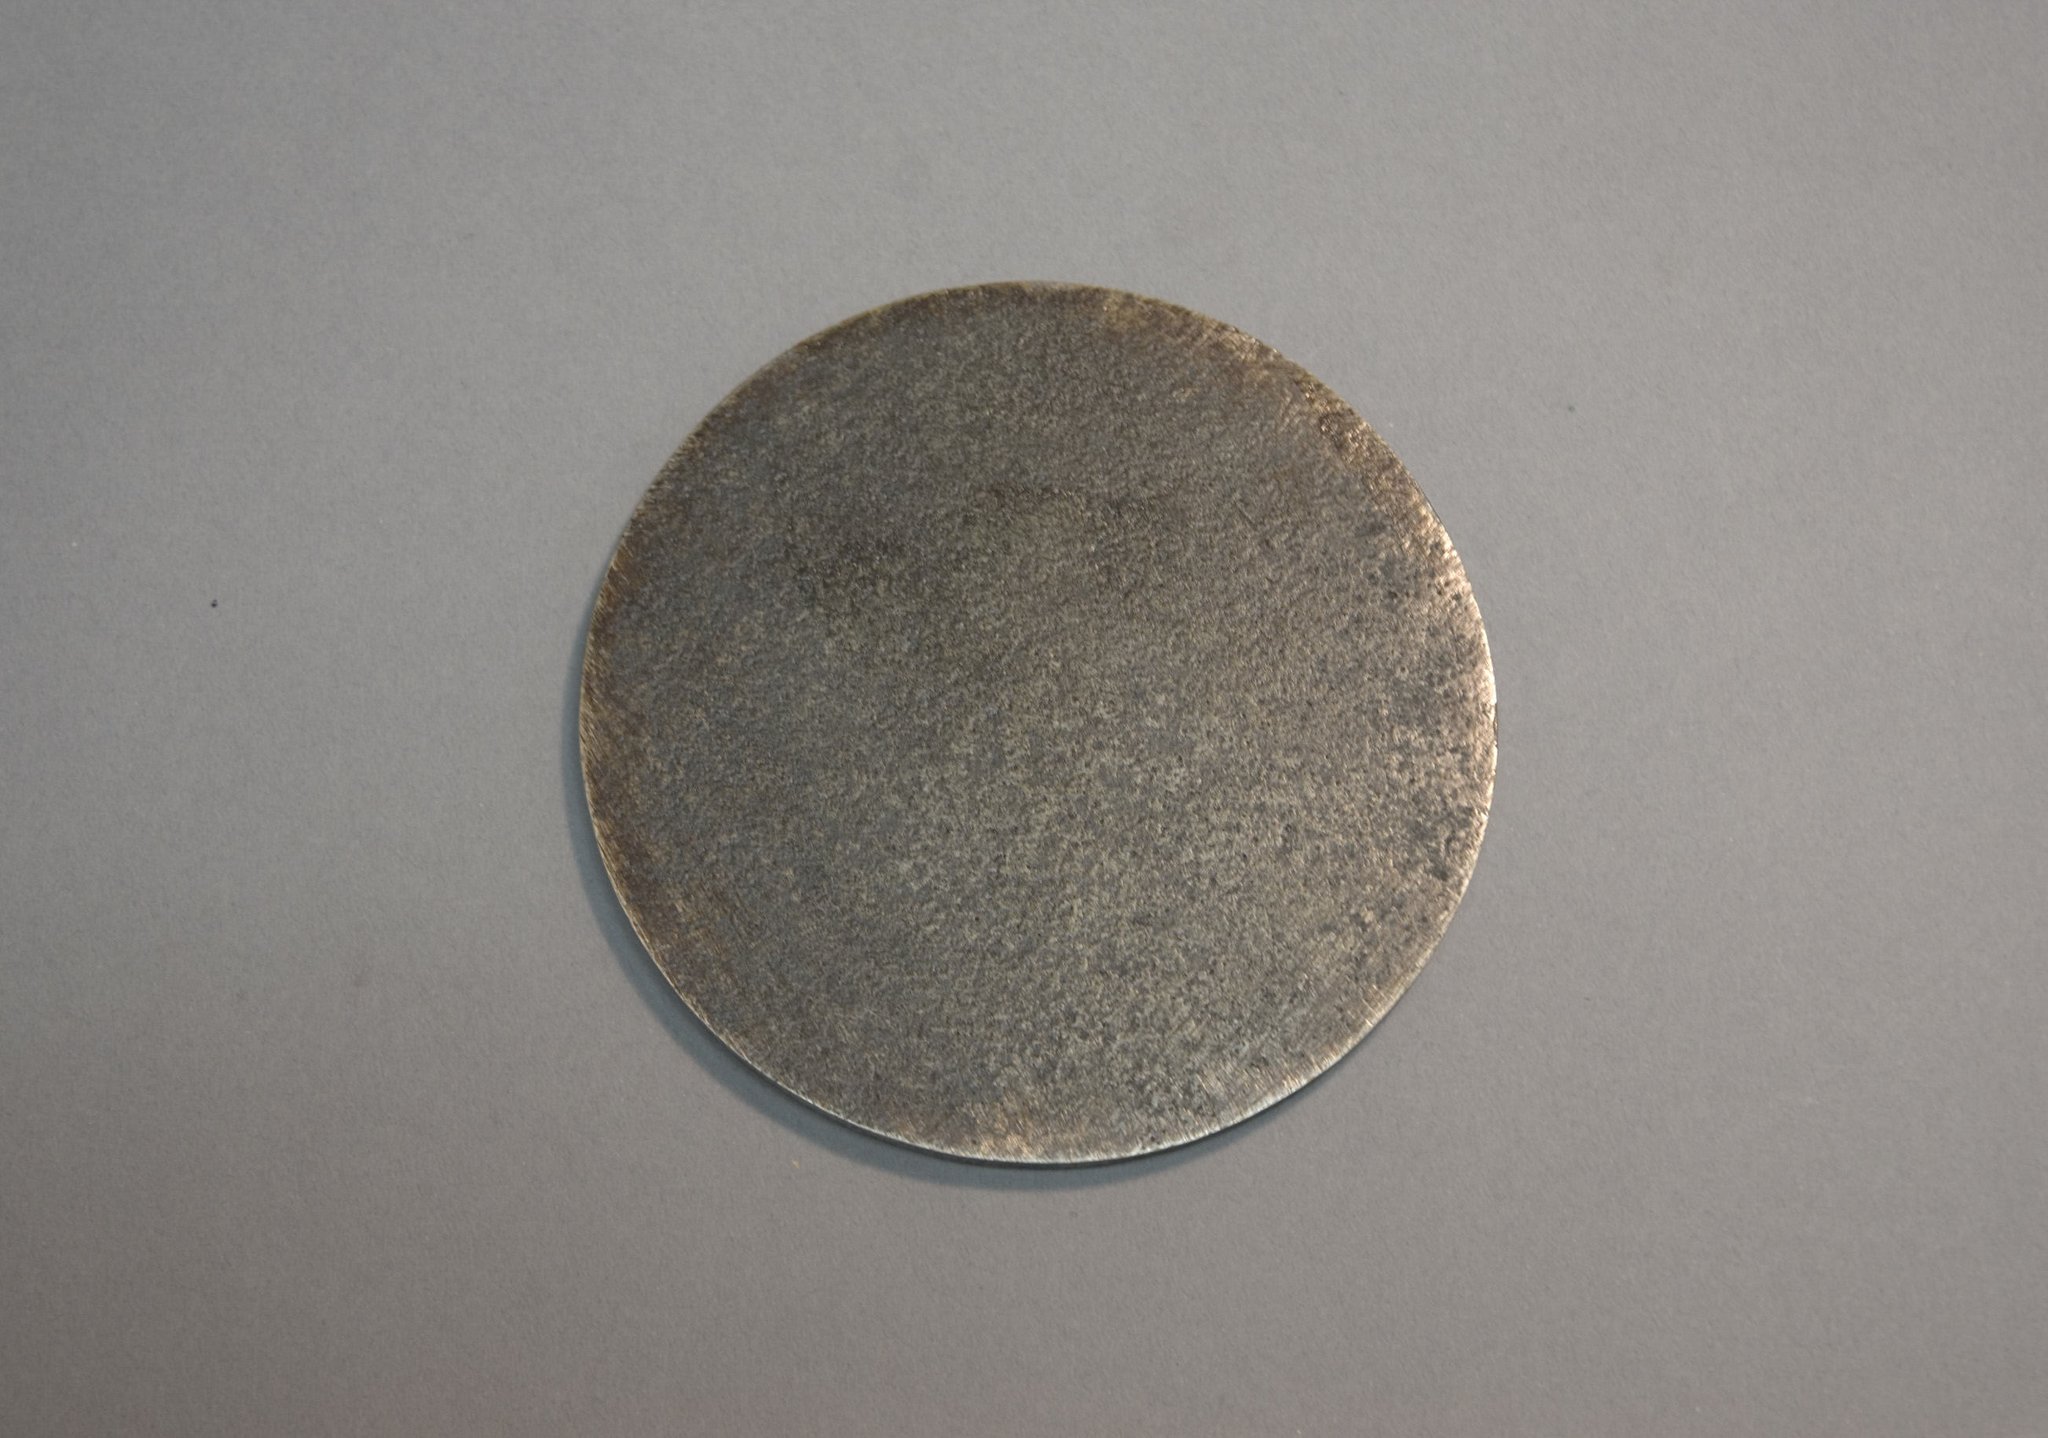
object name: jade carving tool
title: Large Grinder for Jade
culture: chinese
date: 1901-2000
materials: metal